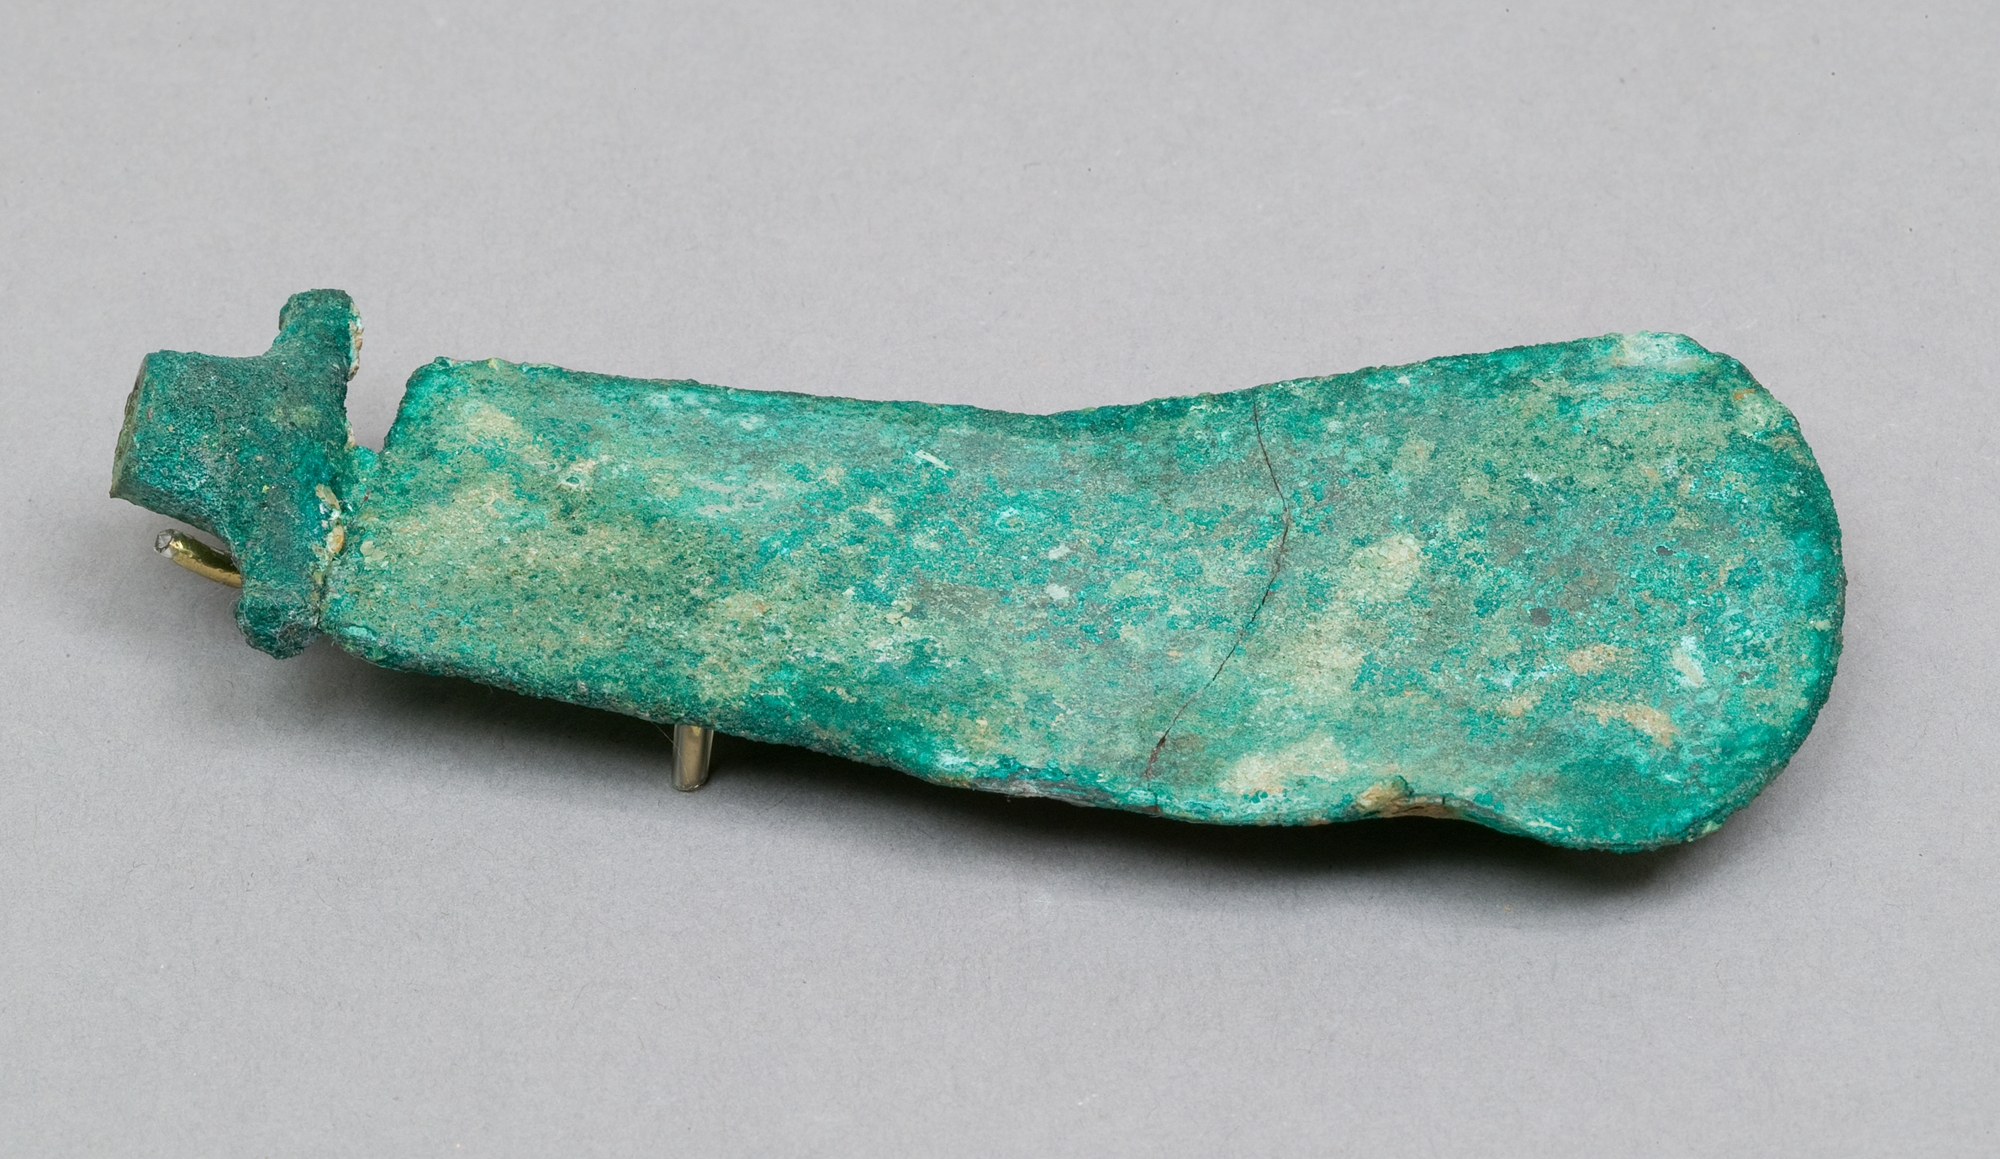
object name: razor, hepy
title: Razor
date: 1950-1885 BCE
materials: bronze, copper alloy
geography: egypt